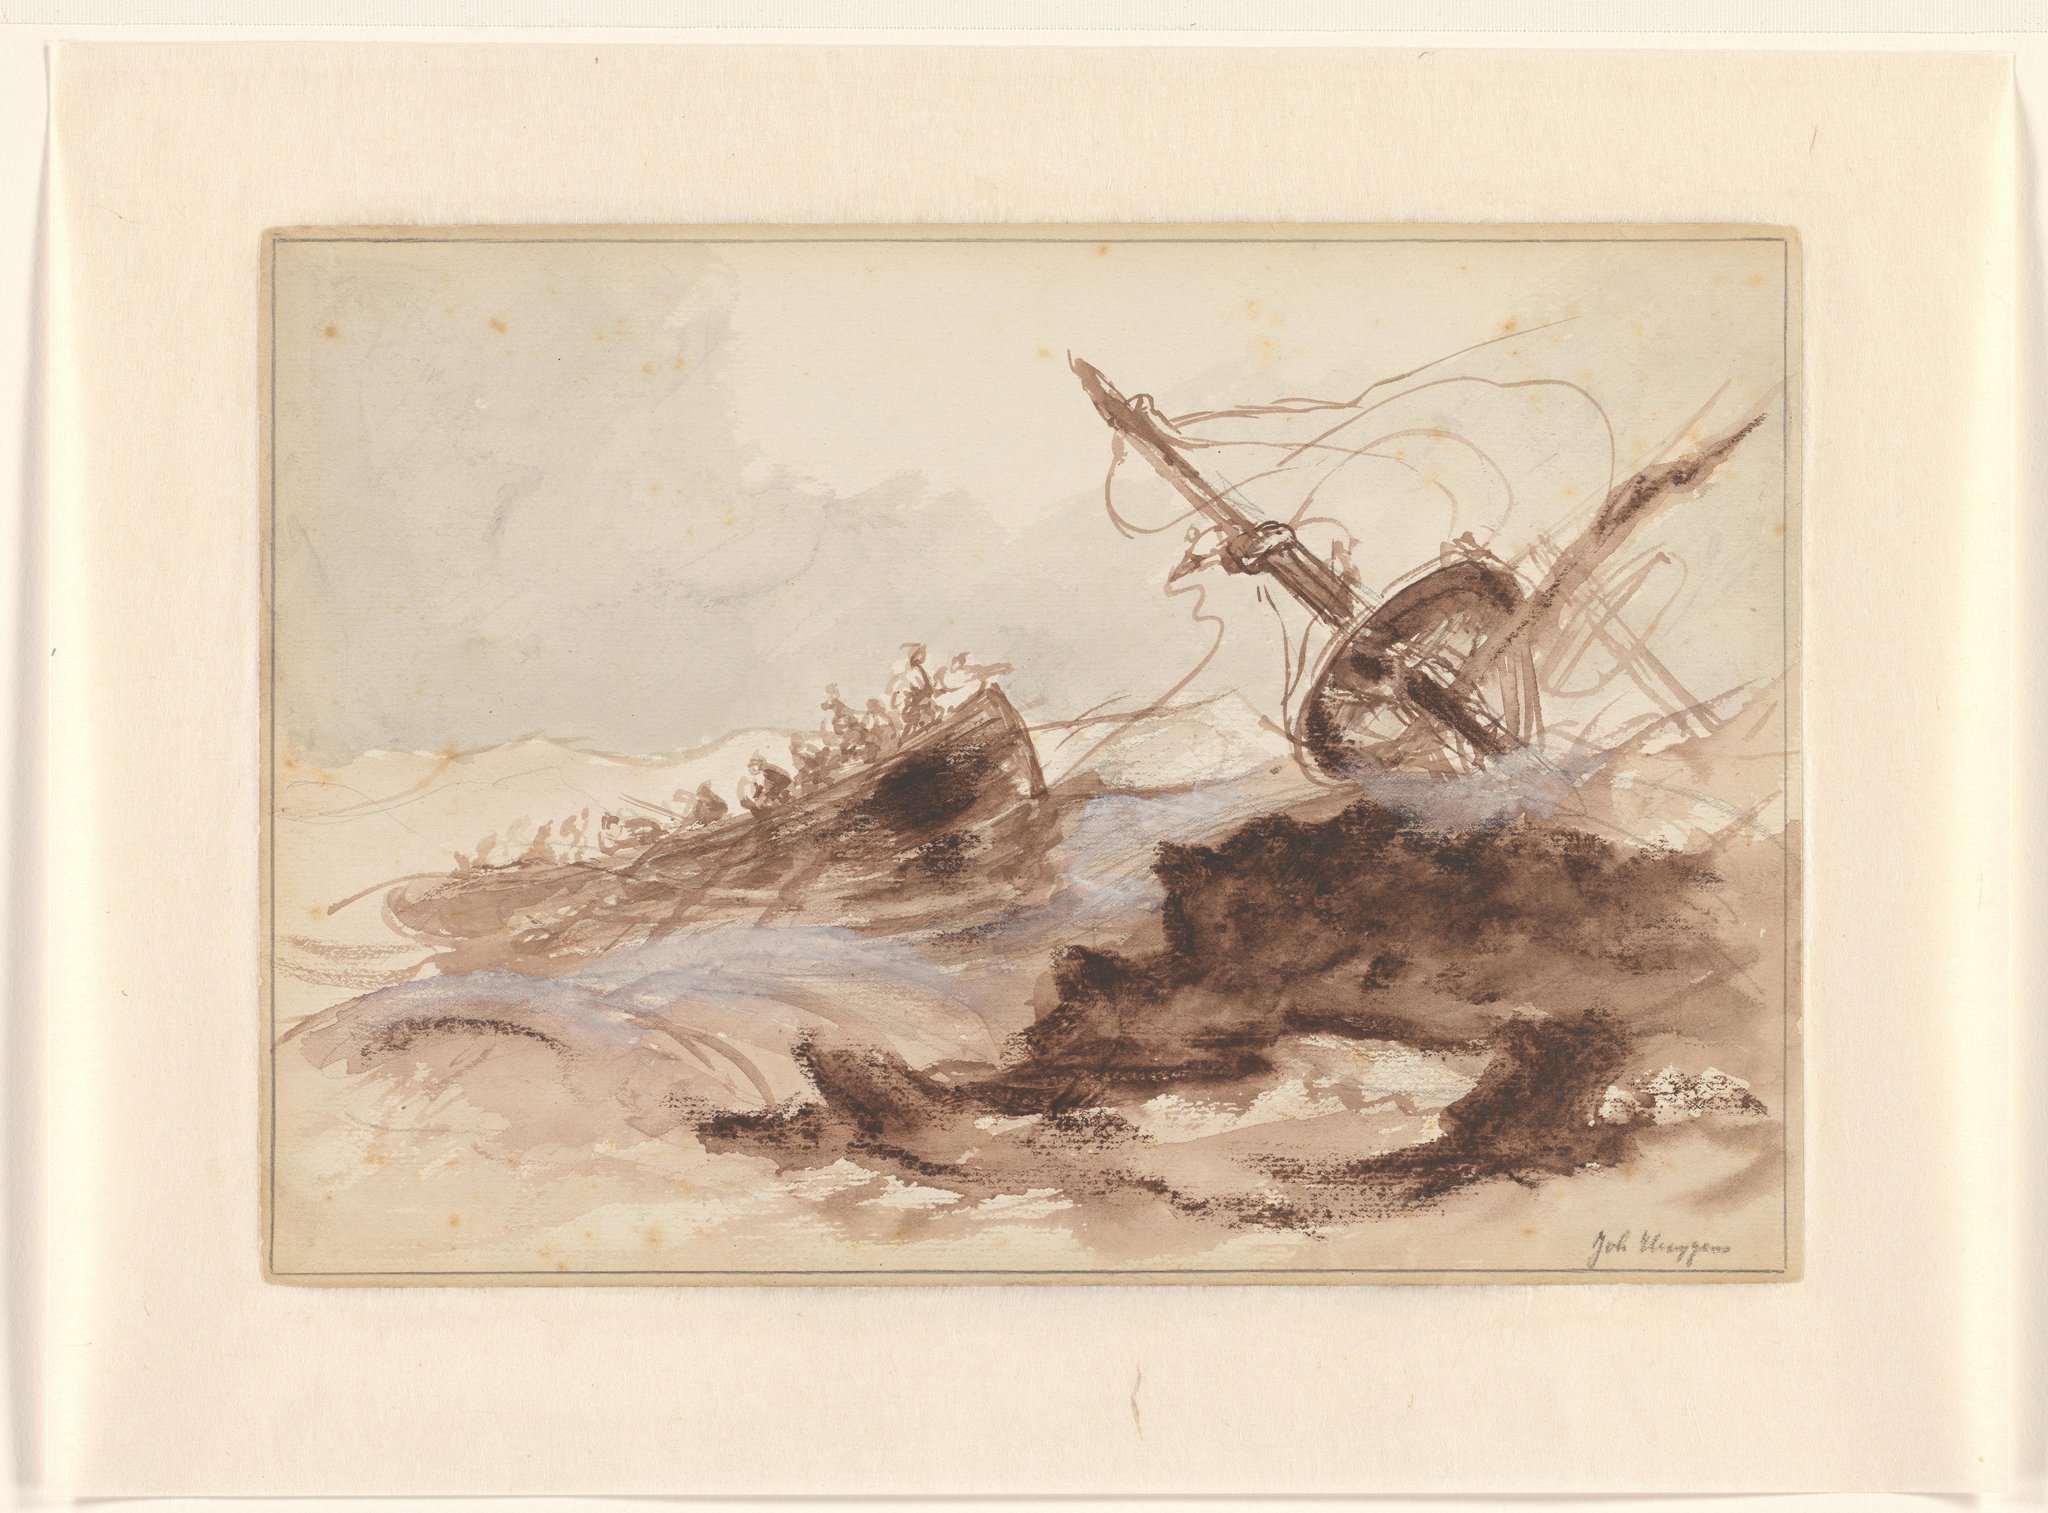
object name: drawing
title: Schipbreuk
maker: johannes huygens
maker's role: draughtsman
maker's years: 1833-1911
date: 1843-1911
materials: paint, ink, paper, pencil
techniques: brush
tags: shipwreck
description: Rechts een hellend schip op een woeste zee. Links een sloep met mensen.